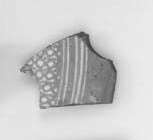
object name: shard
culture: korean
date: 1401-1500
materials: pottery